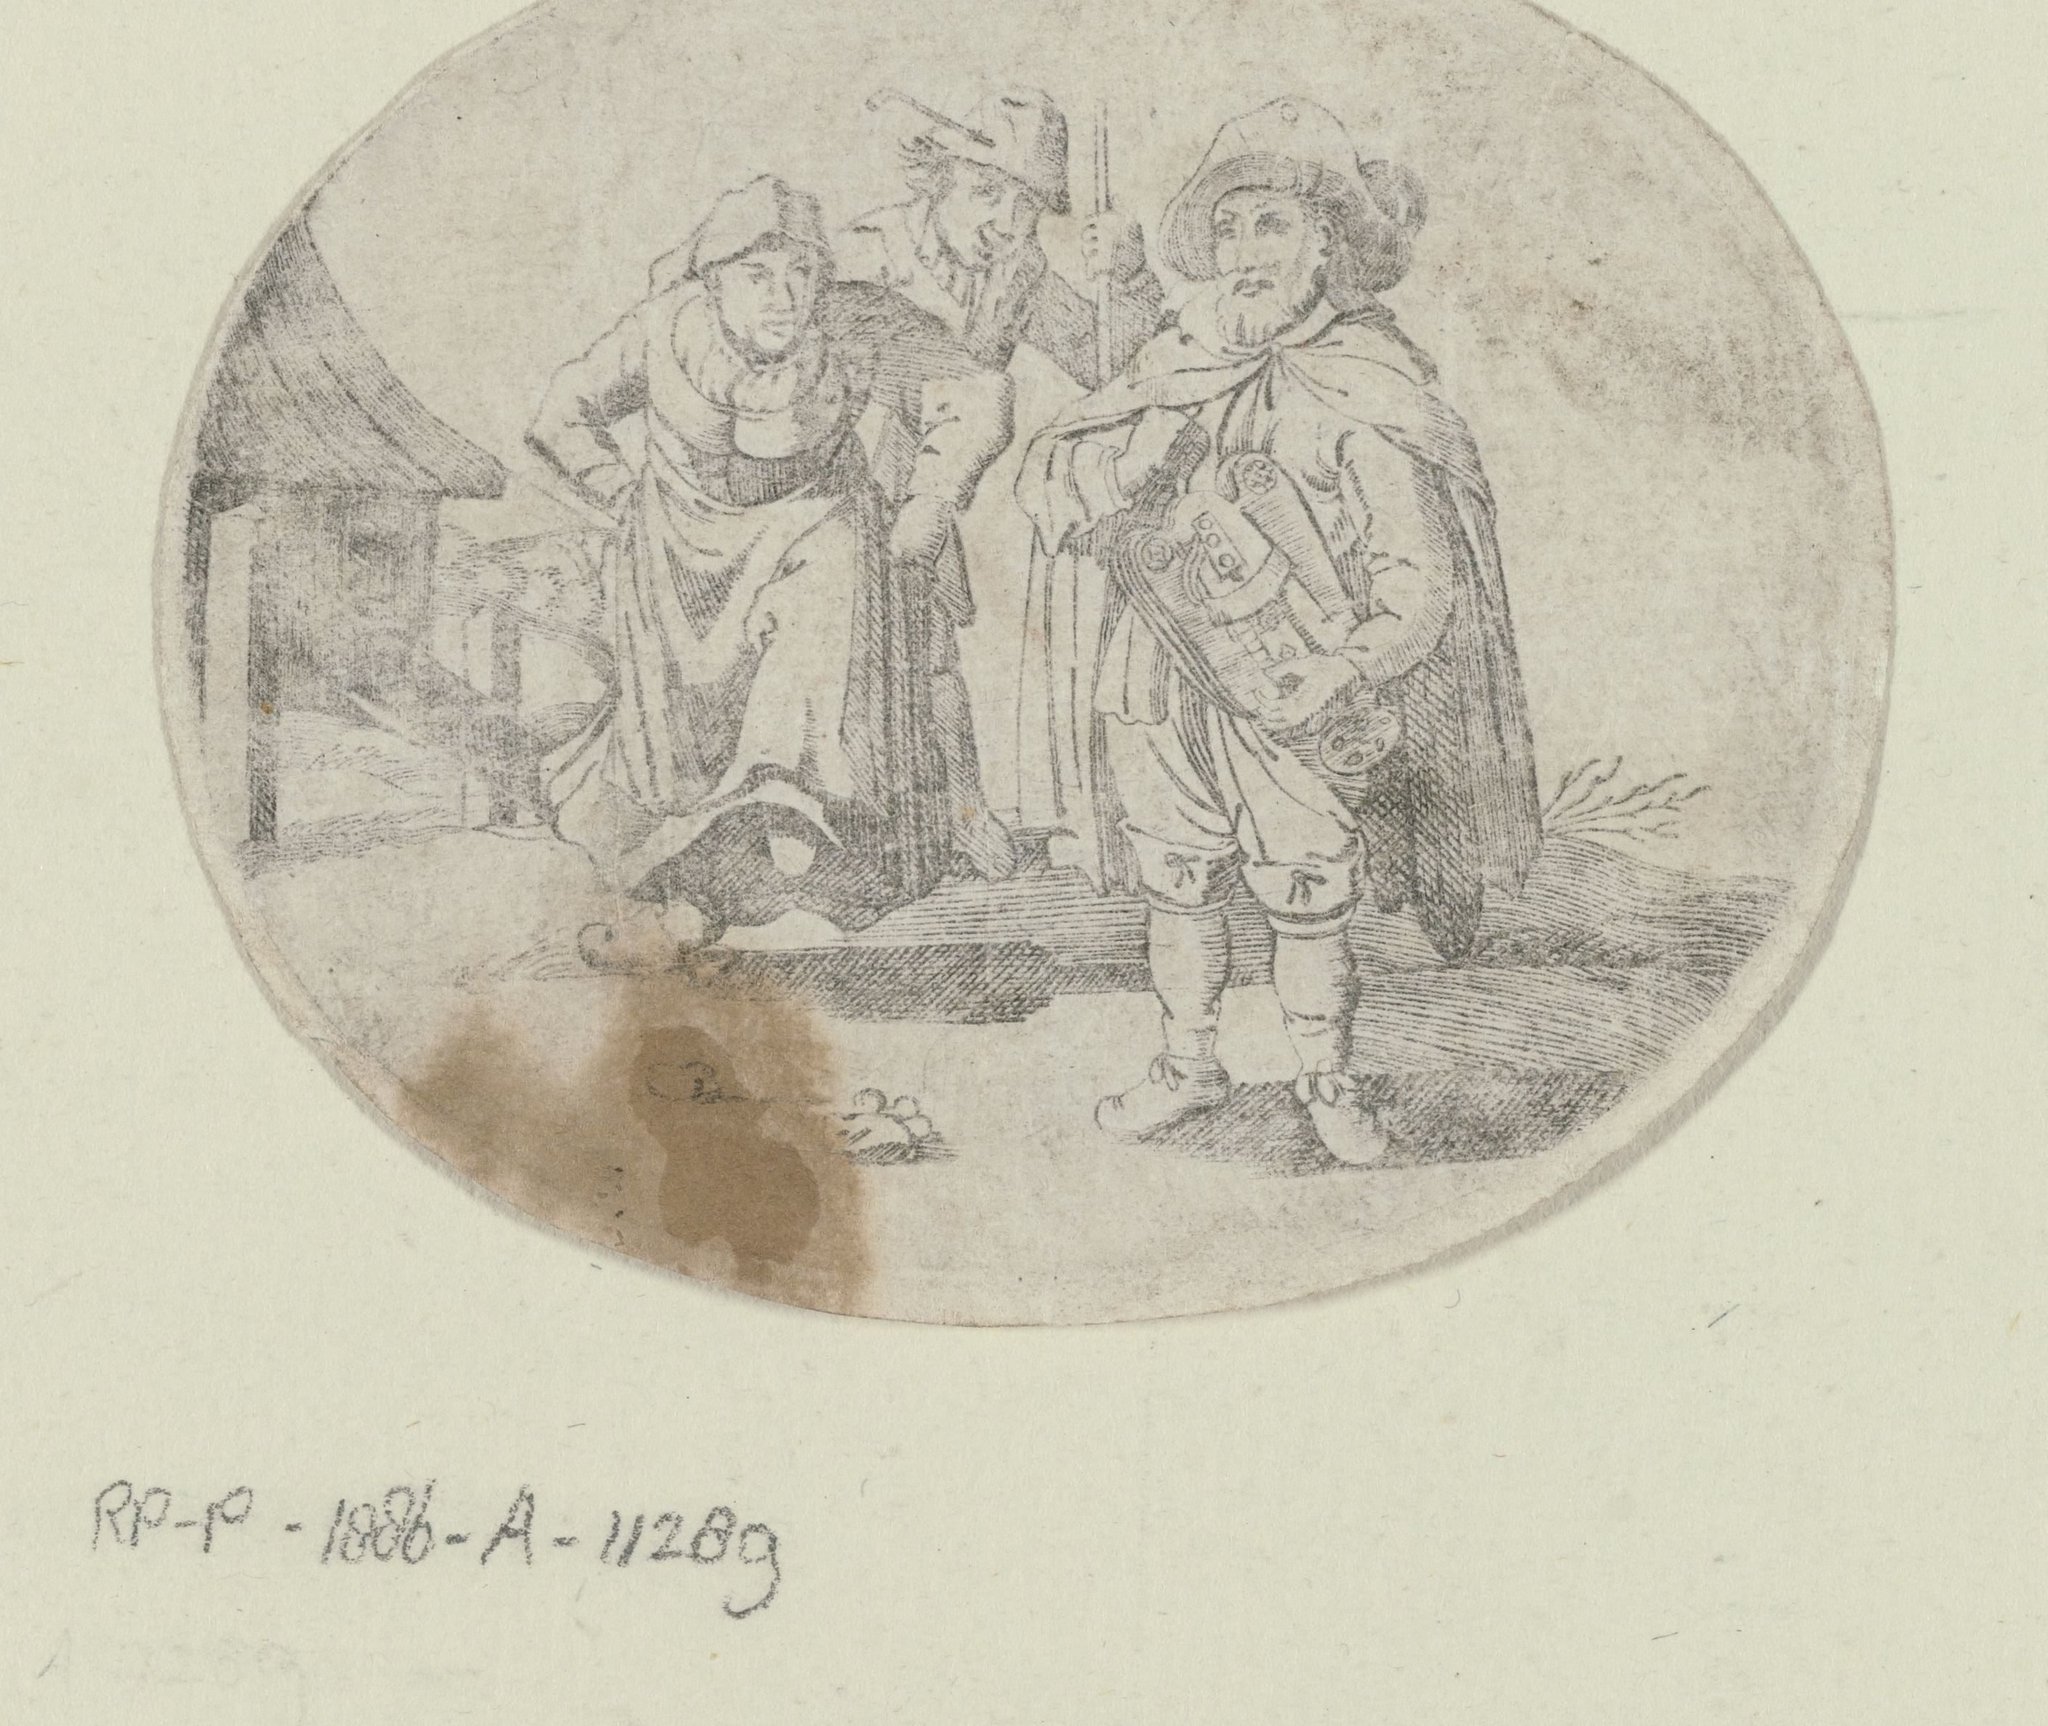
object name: print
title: Man met draailier en dansende vrouw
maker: Anonymous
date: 1650-1750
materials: paper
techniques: etching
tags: woman dancing alone, hurdy-gurdy player - cc - out of doors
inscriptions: collector's mark: Lugt 2228